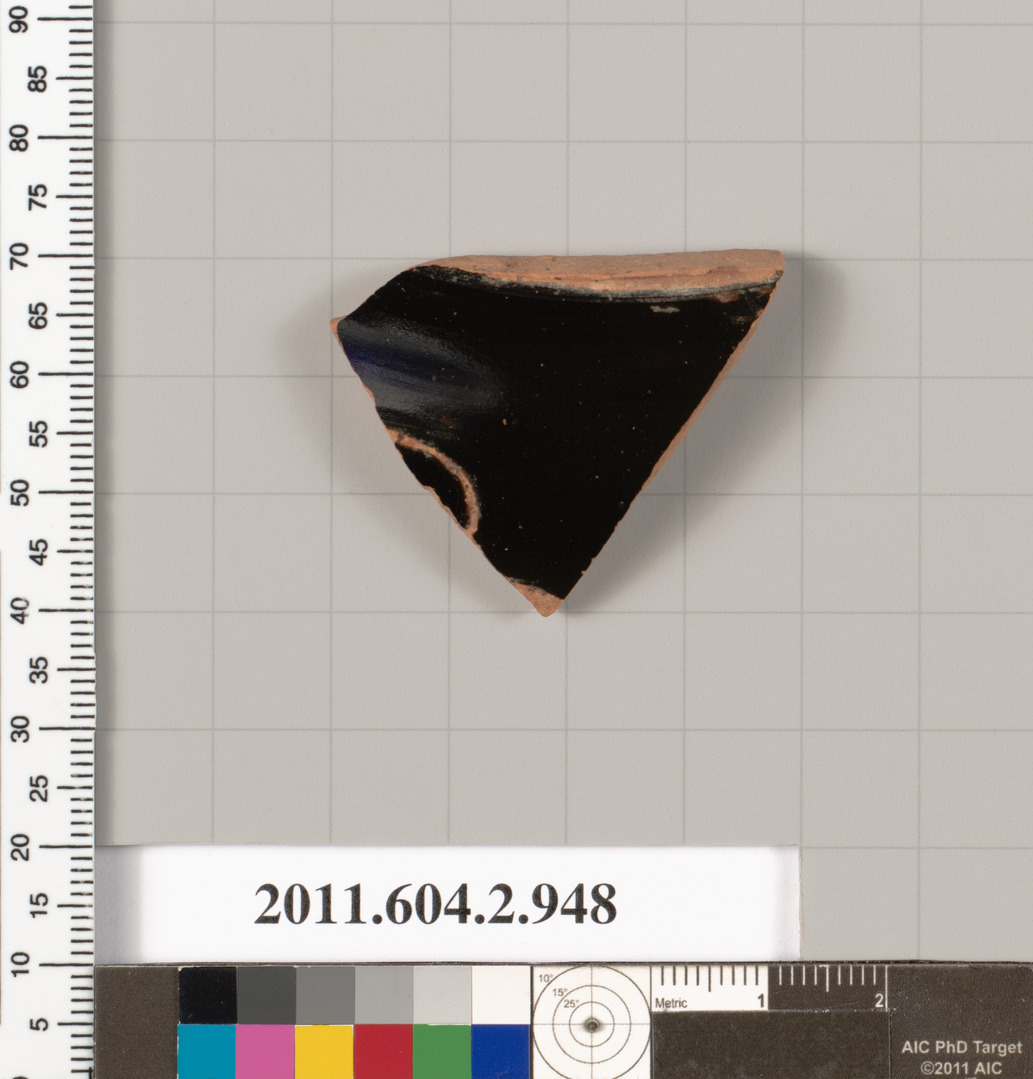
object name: oinochoe fragment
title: Terracotta fragment of an oinochoe (jug)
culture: greek, attic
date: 475-451 BCE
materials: terracotta